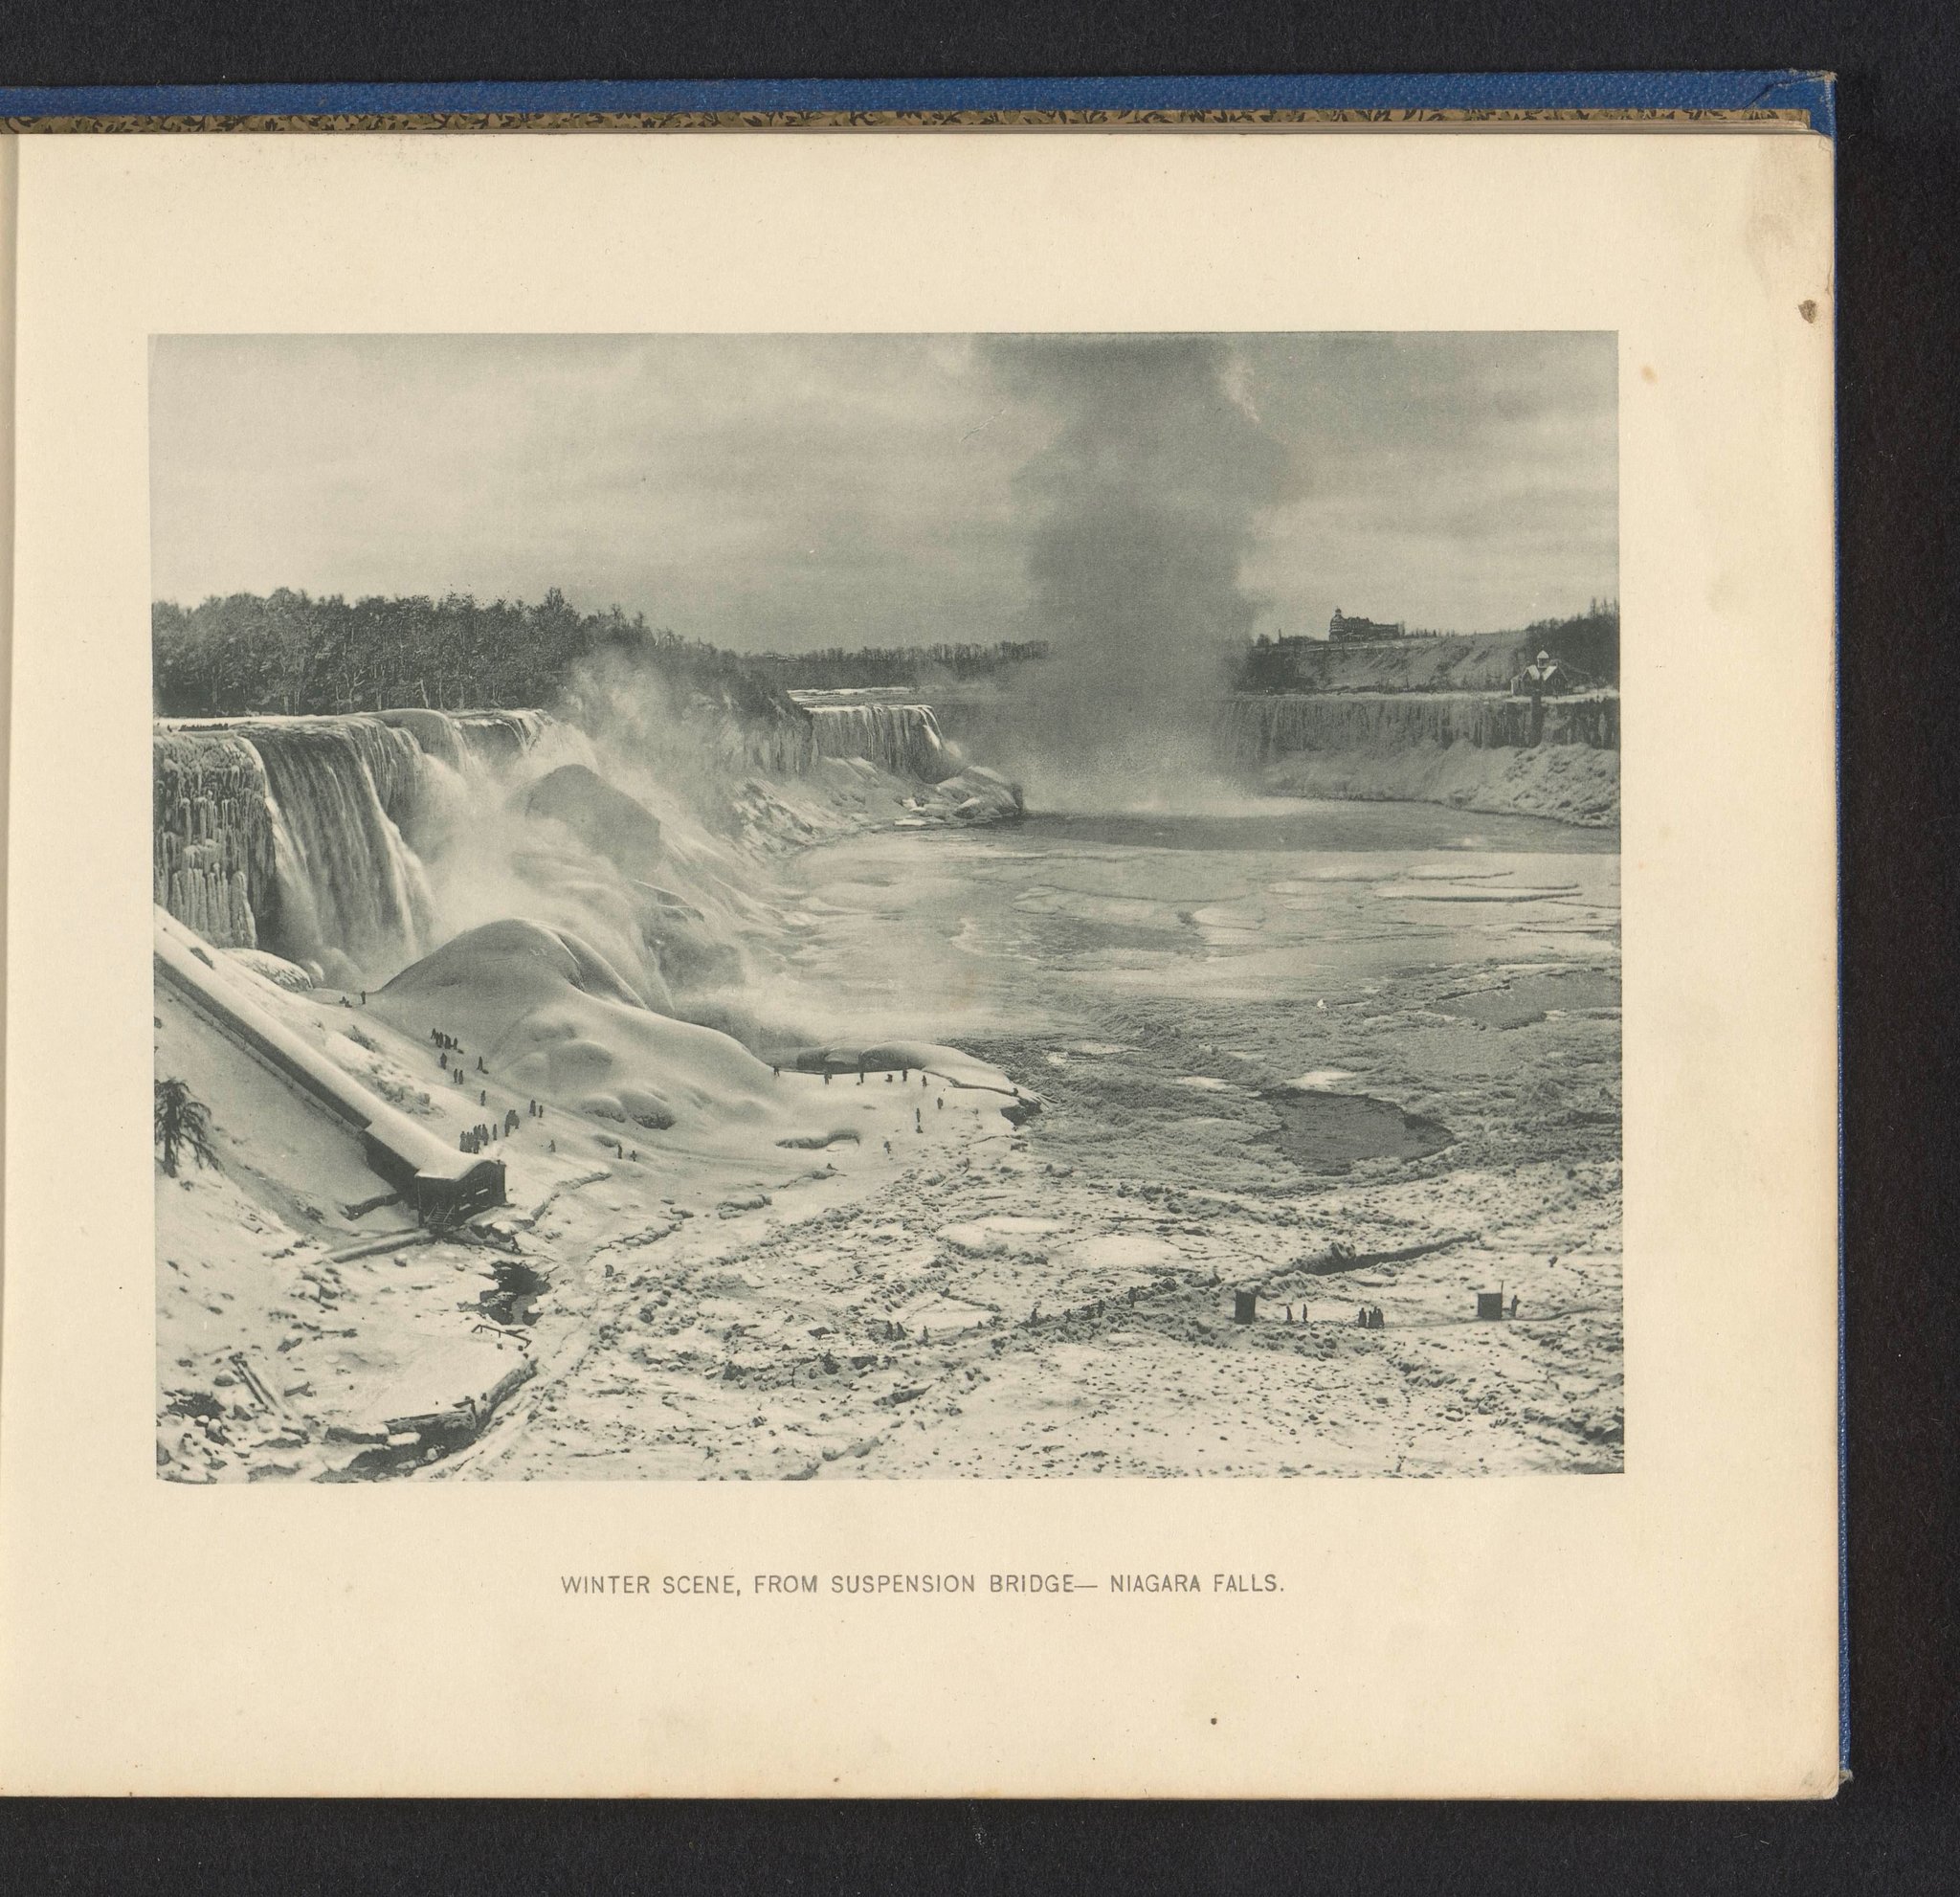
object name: photomechanical print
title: Winter scene, from suspension Bridge - Niagara Falls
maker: Anonymous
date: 1883-1893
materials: paper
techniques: photograph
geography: new york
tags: waterfall